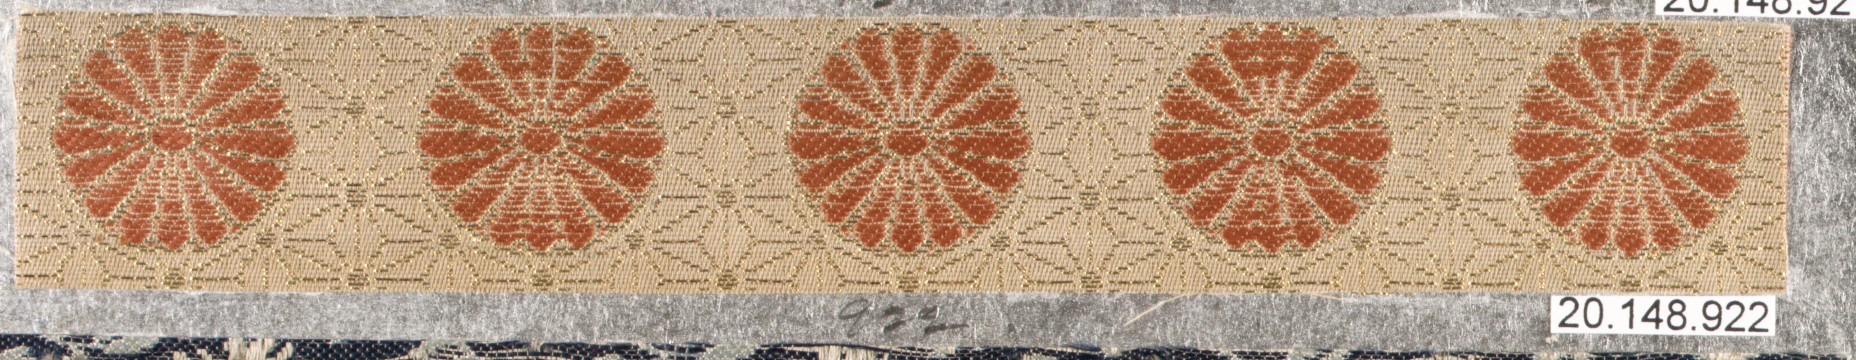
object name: piece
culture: japanese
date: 1701-1800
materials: silk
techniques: compound weave